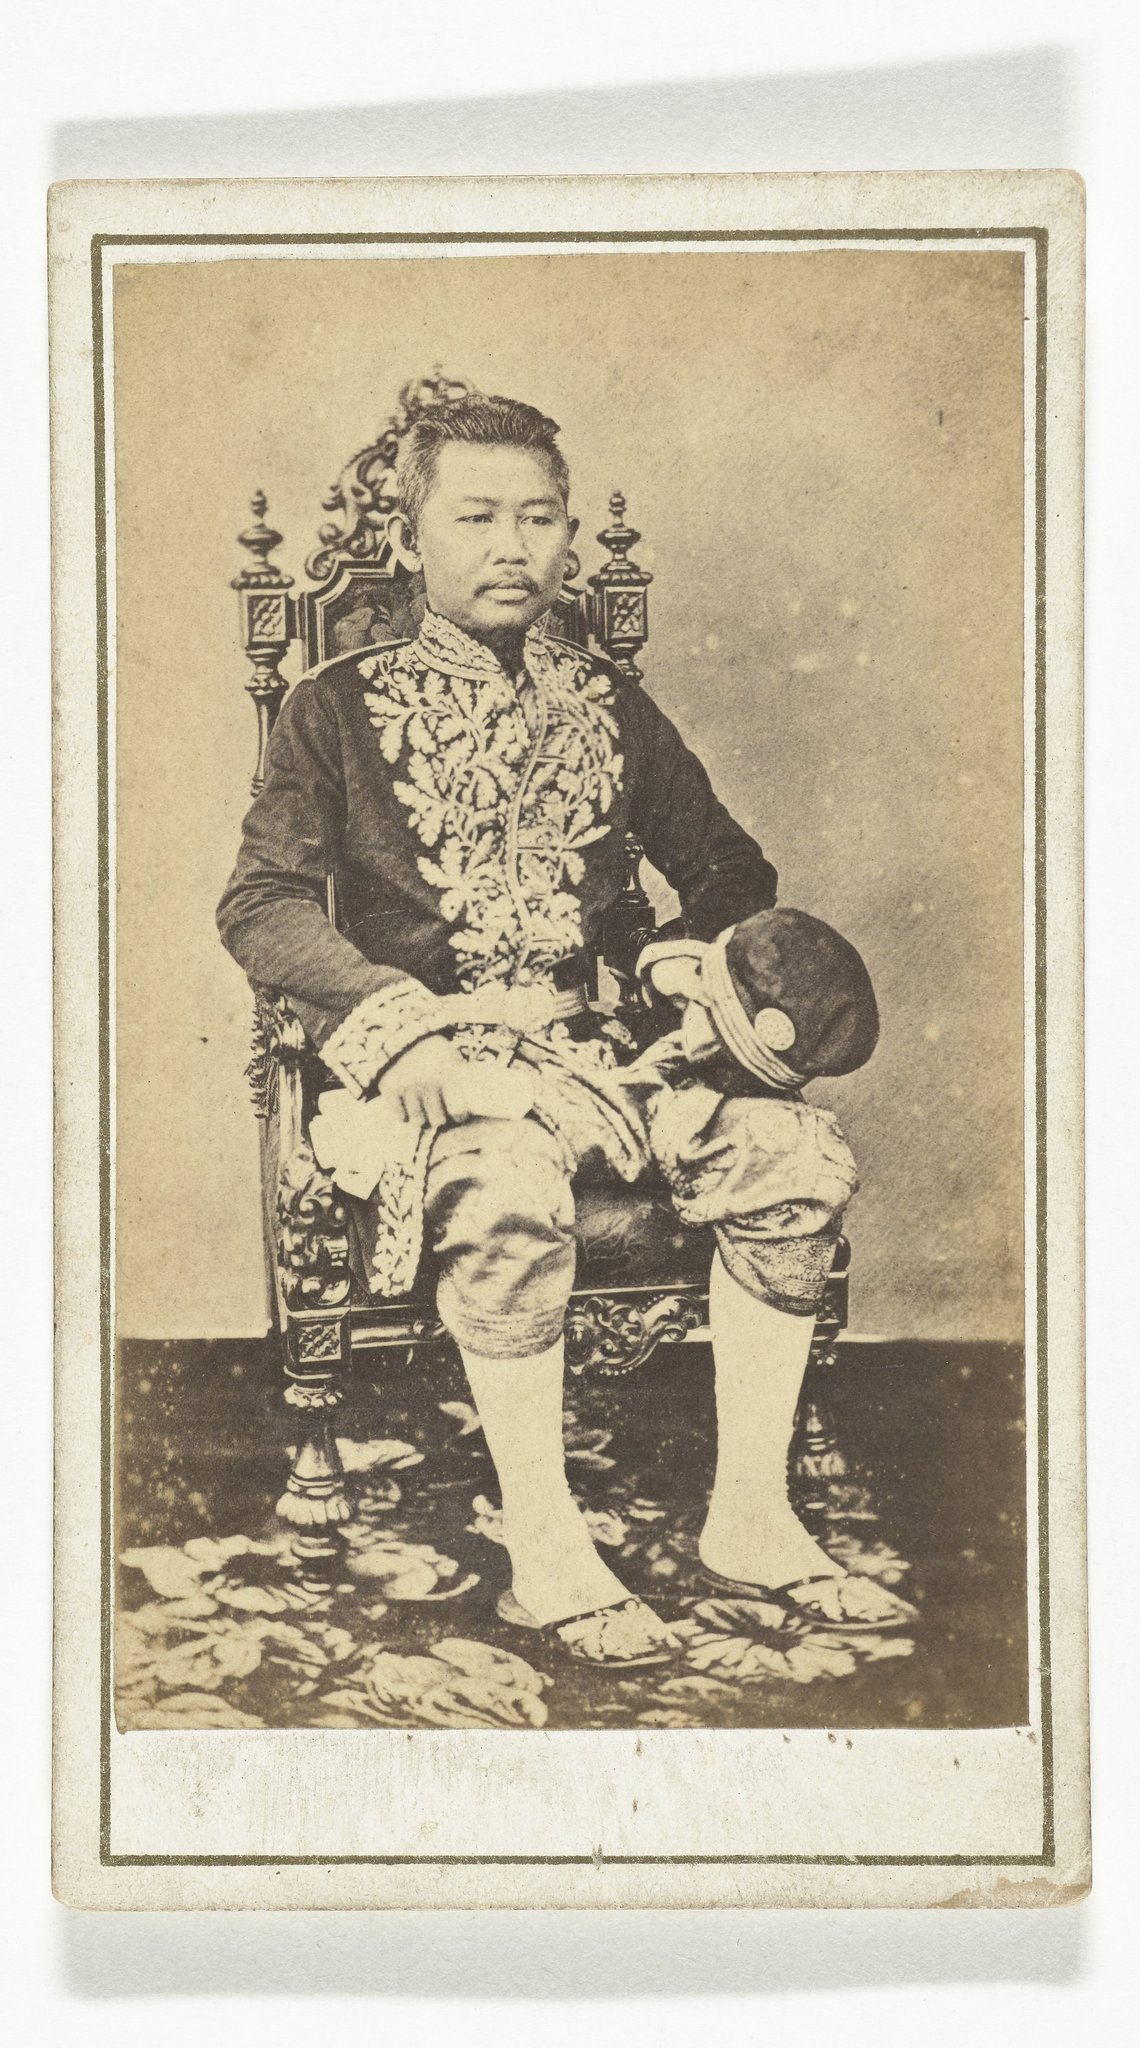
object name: carte de visite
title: Portret van de prins van Siam zittend op een stoel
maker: francis ghit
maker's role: fotograaf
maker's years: 1830-1891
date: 1870-1900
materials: cardboard, paper, photographic support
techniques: albumen print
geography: bangkok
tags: historical persons, king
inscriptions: signature: ‘F. Ghit photographer Sta Cruz Bangkok’, title: ‘Prins van Siam’